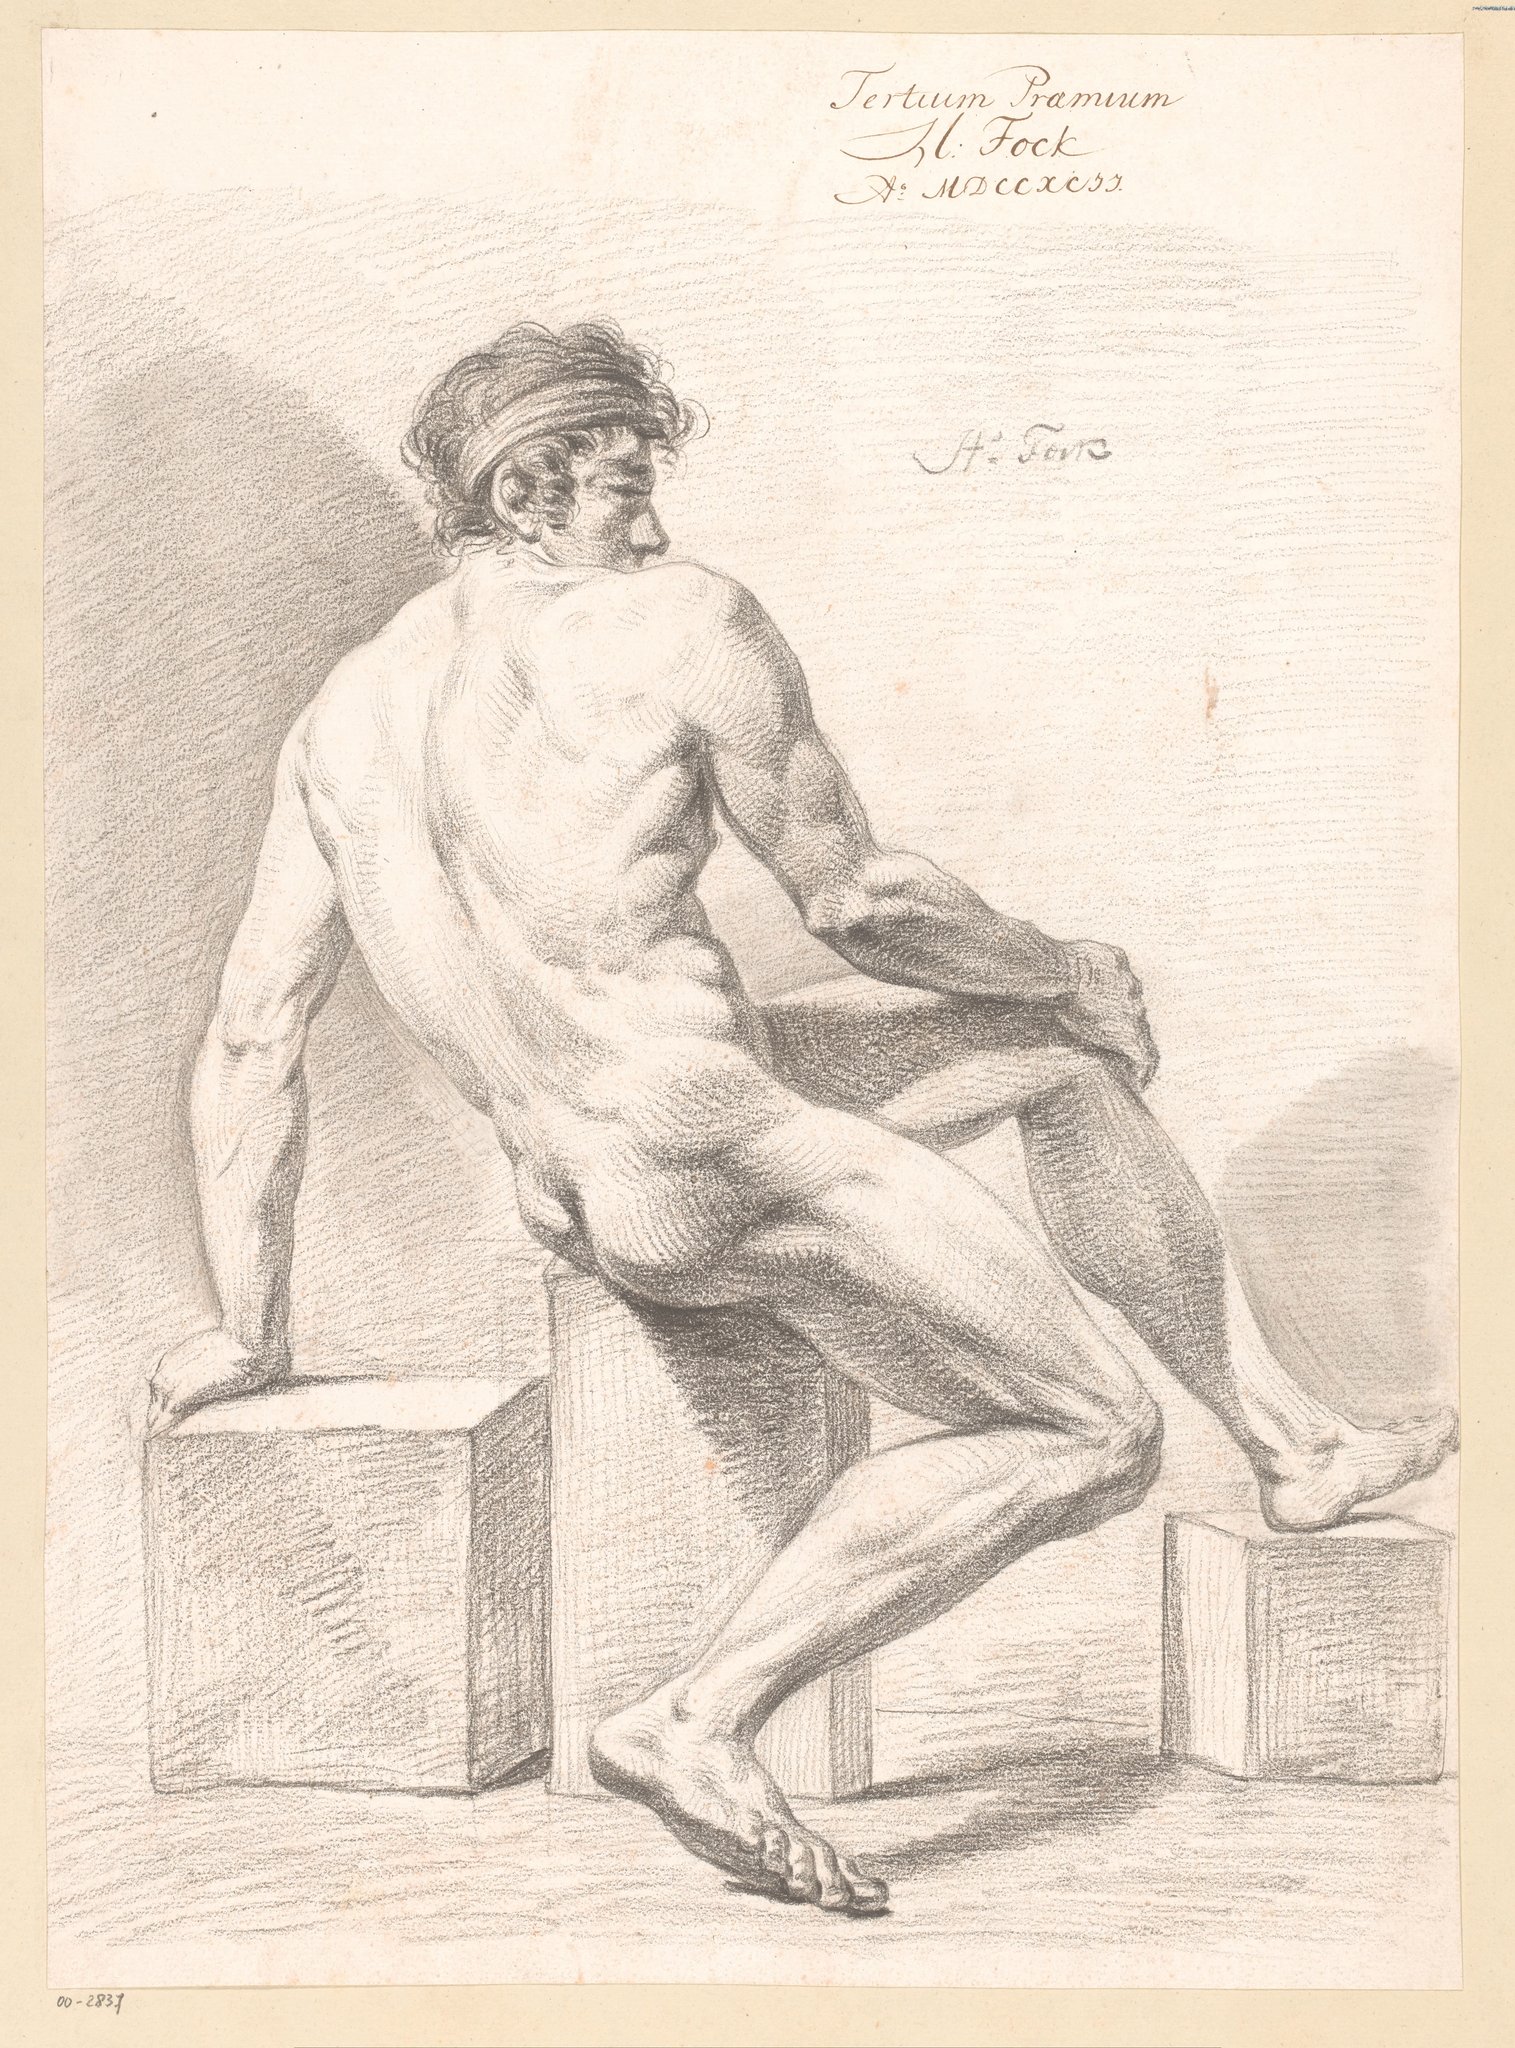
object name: drawing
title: Zittend mannelijk naakt, op de rug gezien (3e prijs 1792)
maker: hermanus fock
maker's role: conservator, draughtsman, painter, print maker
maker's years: 1766-1822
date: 1792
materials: chalk, paper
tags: sitting figure (+ nude human being)